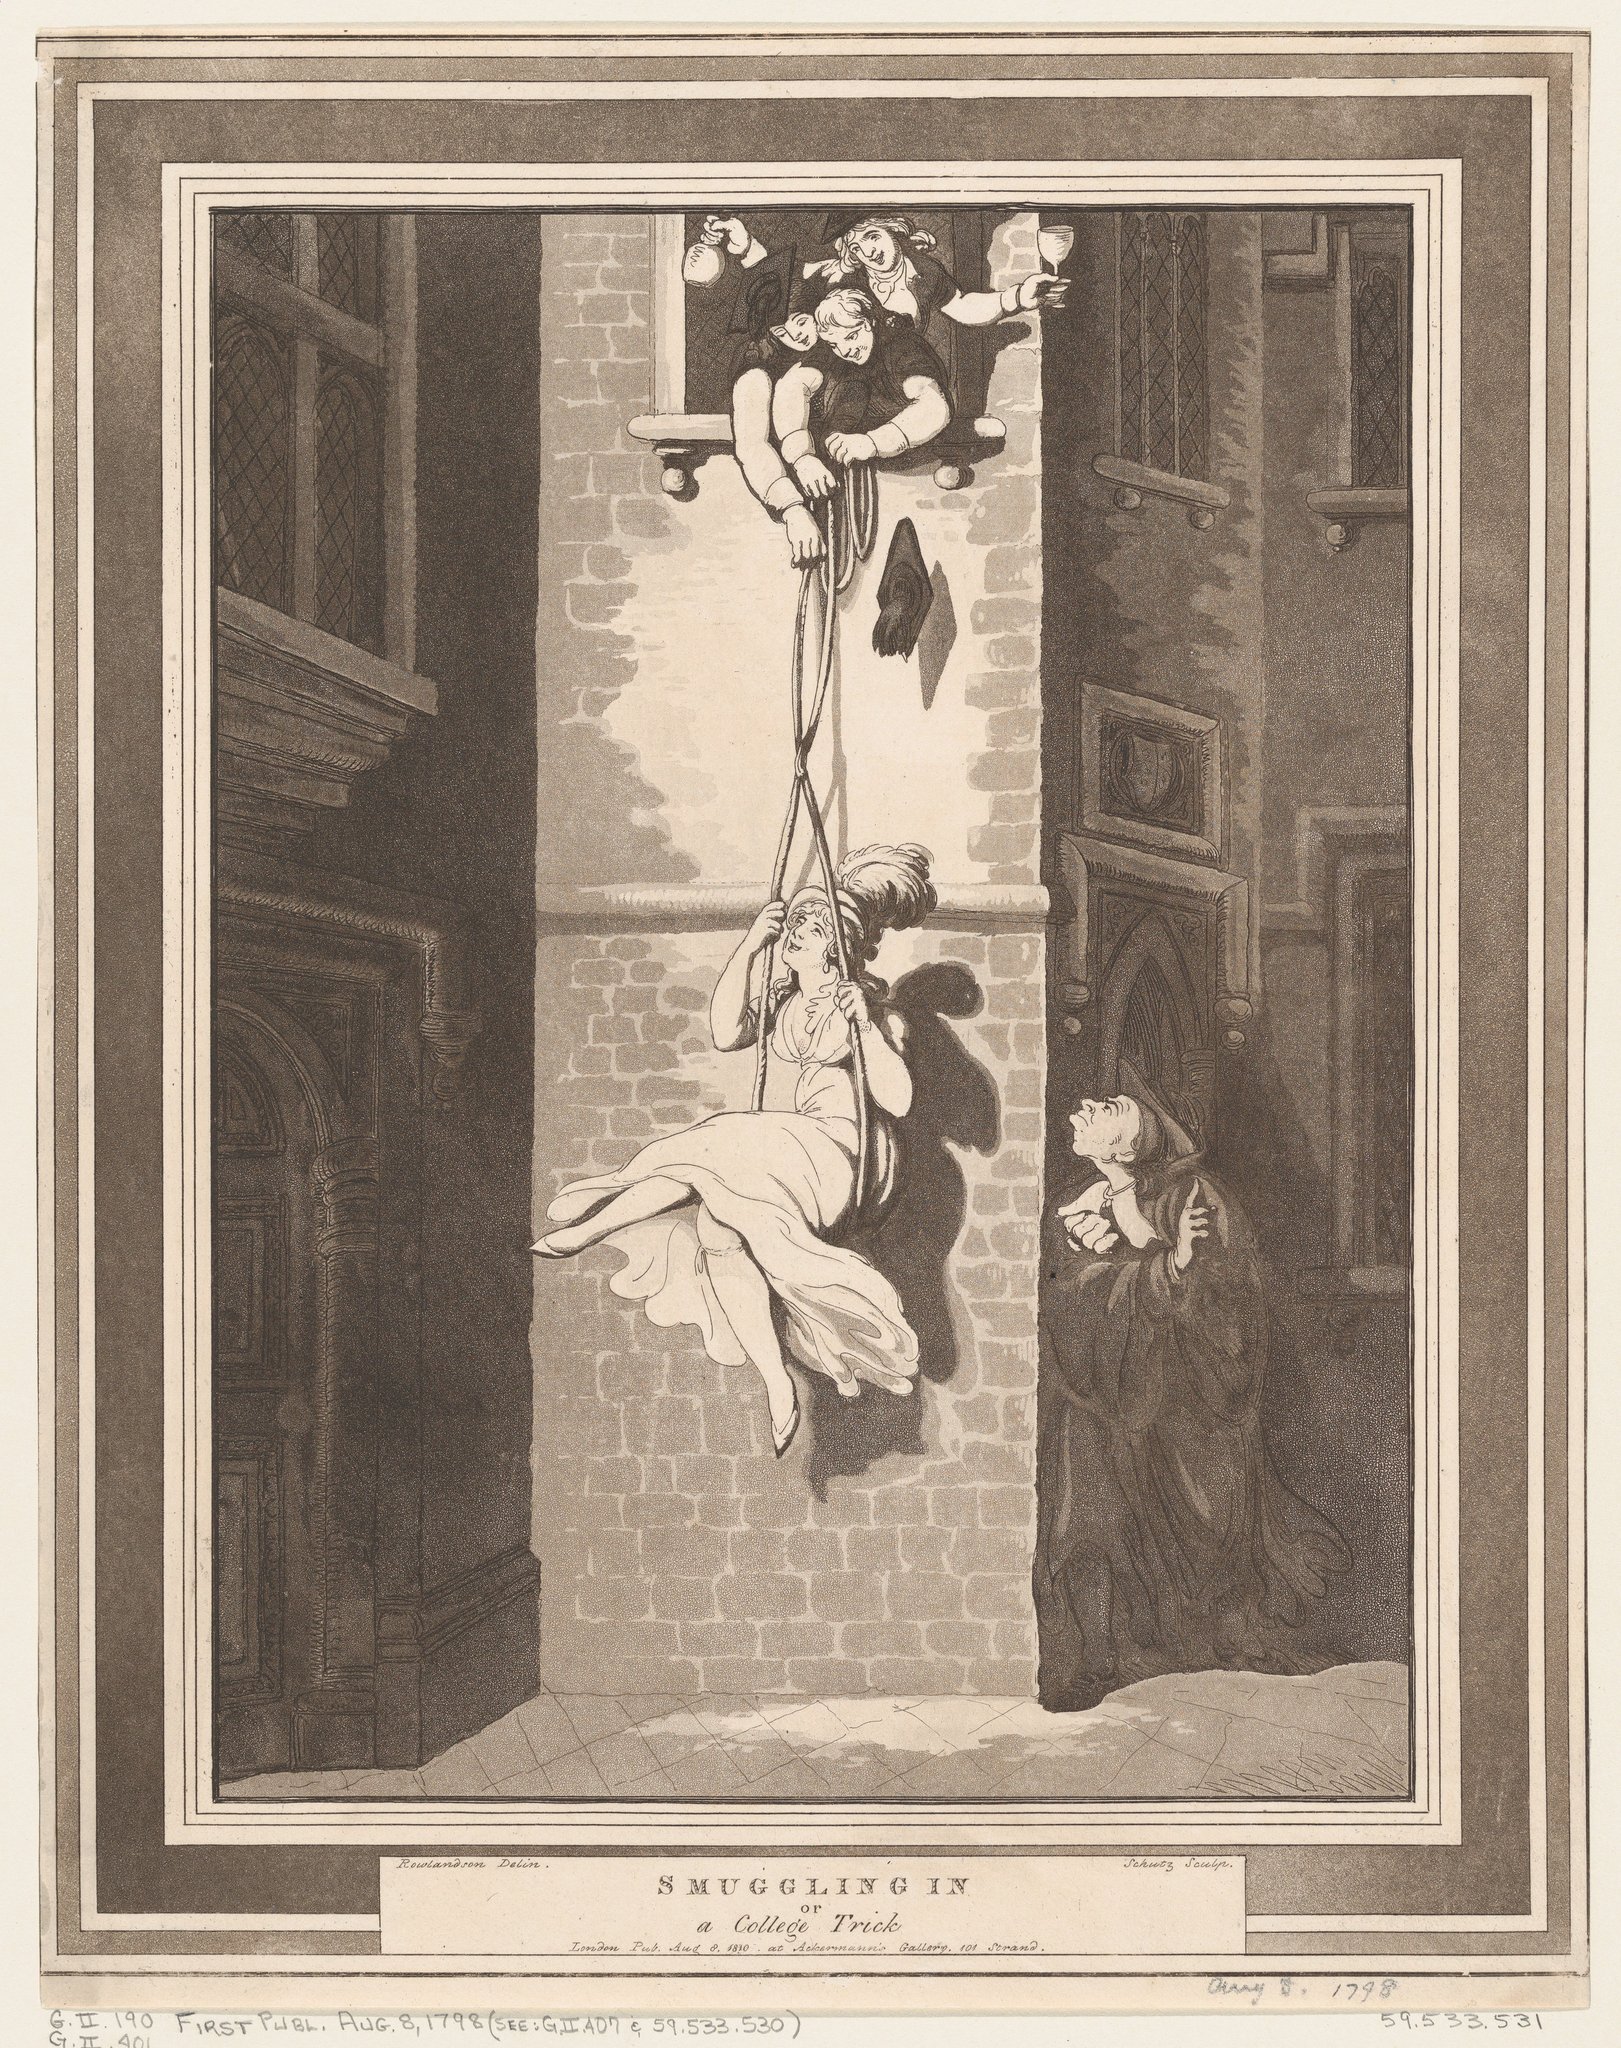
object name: print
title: Smuggling In, or A College Trick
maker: heinrich joseph schütz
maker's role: artist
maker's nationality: german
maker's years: 1800-1825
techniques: aquatint, etching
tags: men,women